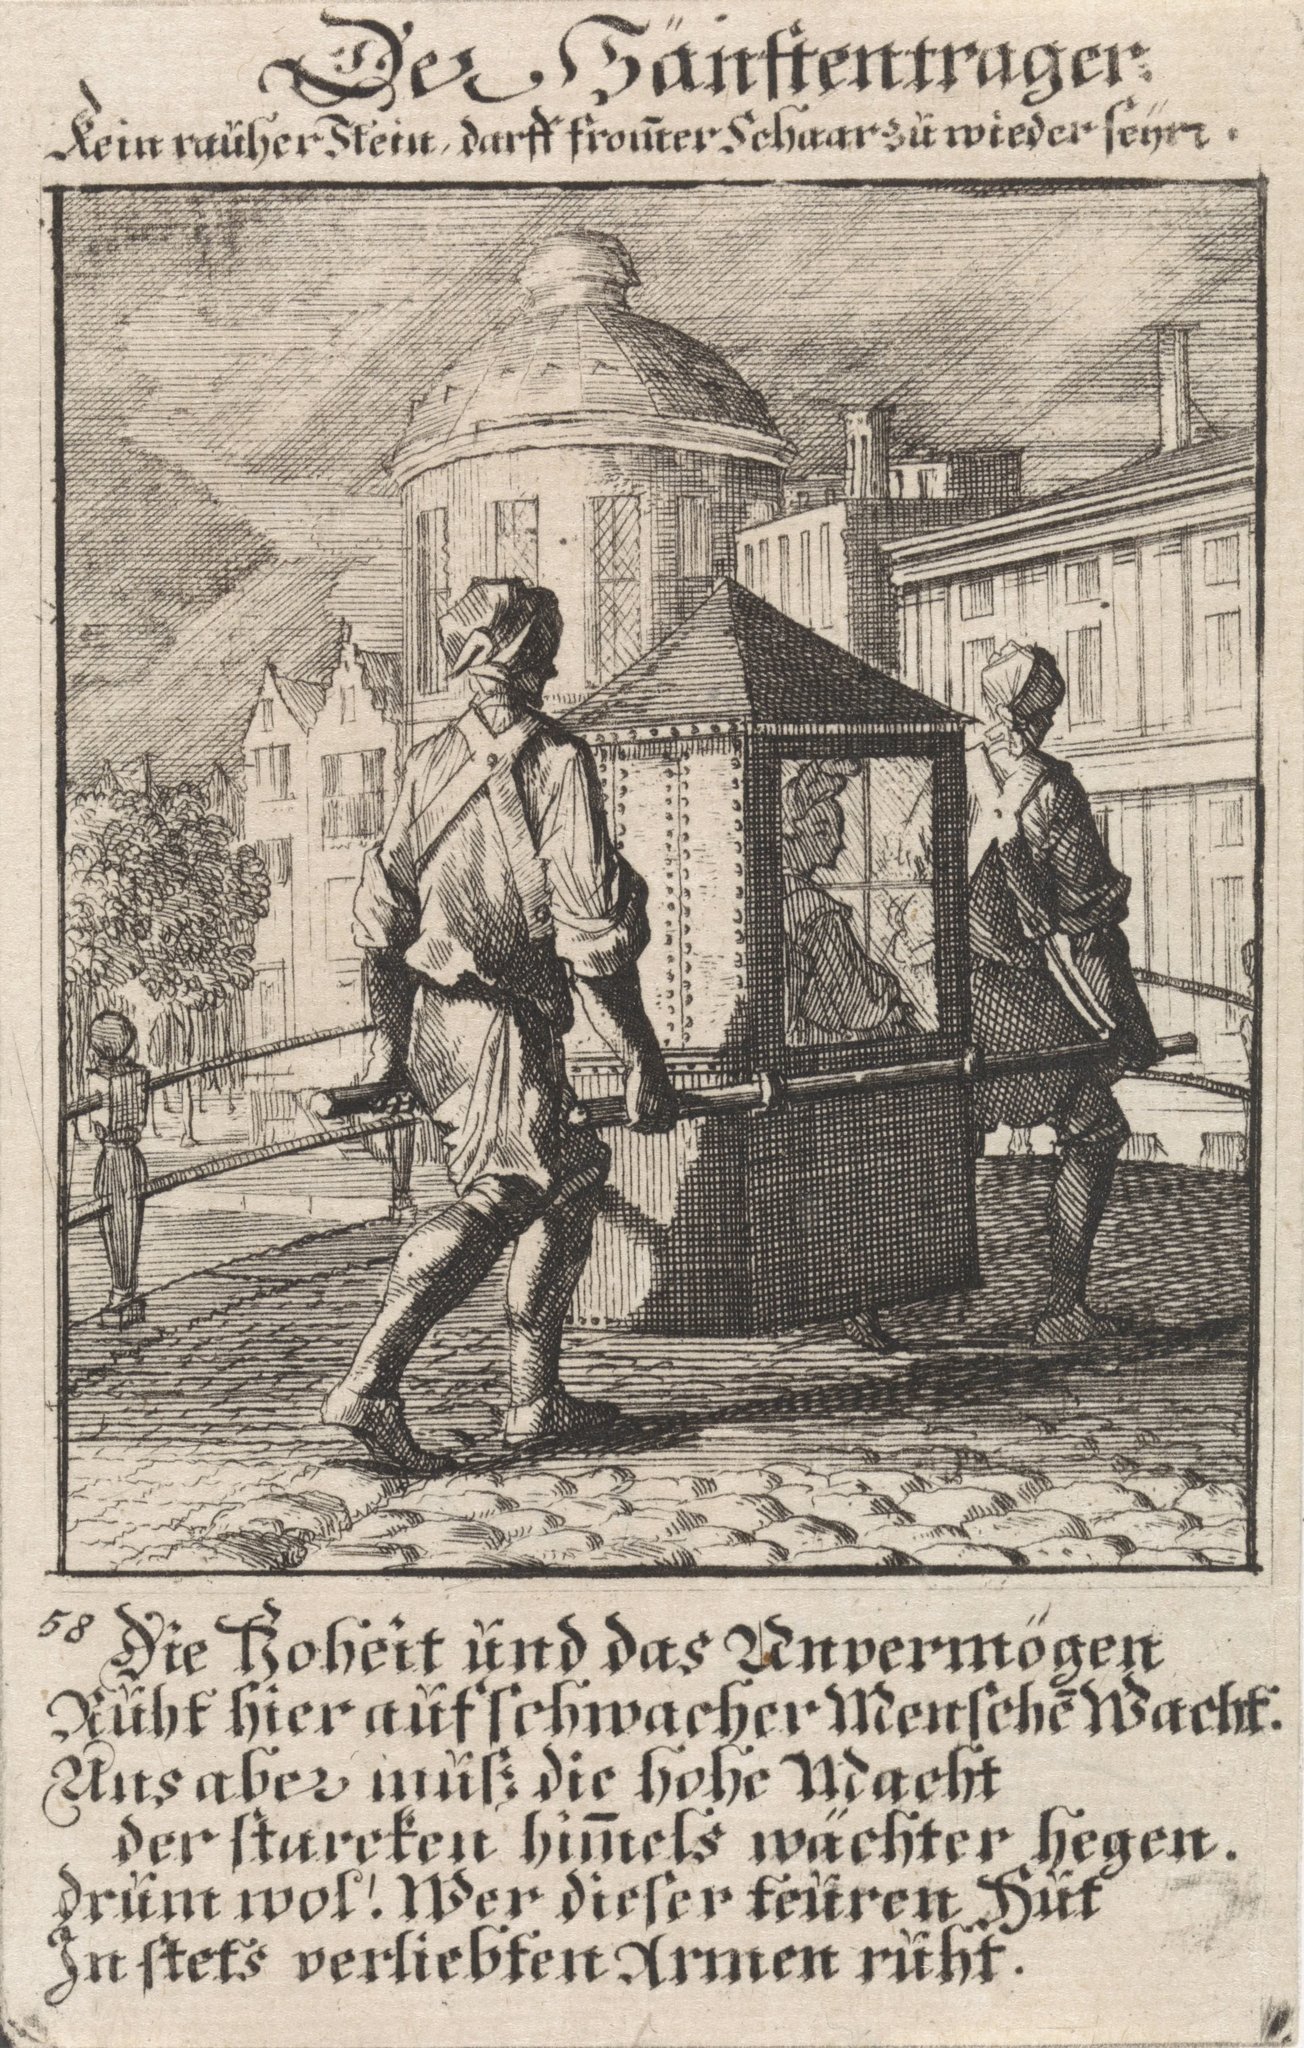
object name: book illustration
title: Der Sänftentrager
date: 1711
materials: paper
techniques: etching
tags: (carrying a person in a) sedan-chair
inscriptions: collector's mark: Lugt 2228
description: Illustratie uit: Sancta Clara, Abraham à. Etwas für Alle, das ist: Eine kurtze Beschreibung allerley Stands- Ambts- und Gewerbs-Persohnen (...), 3 delen (1699-1733). Würtzburg: Martin Frantz Hertz, 1711, dl. III, p. 546. Het betreft hier de tweede druk van deel III.